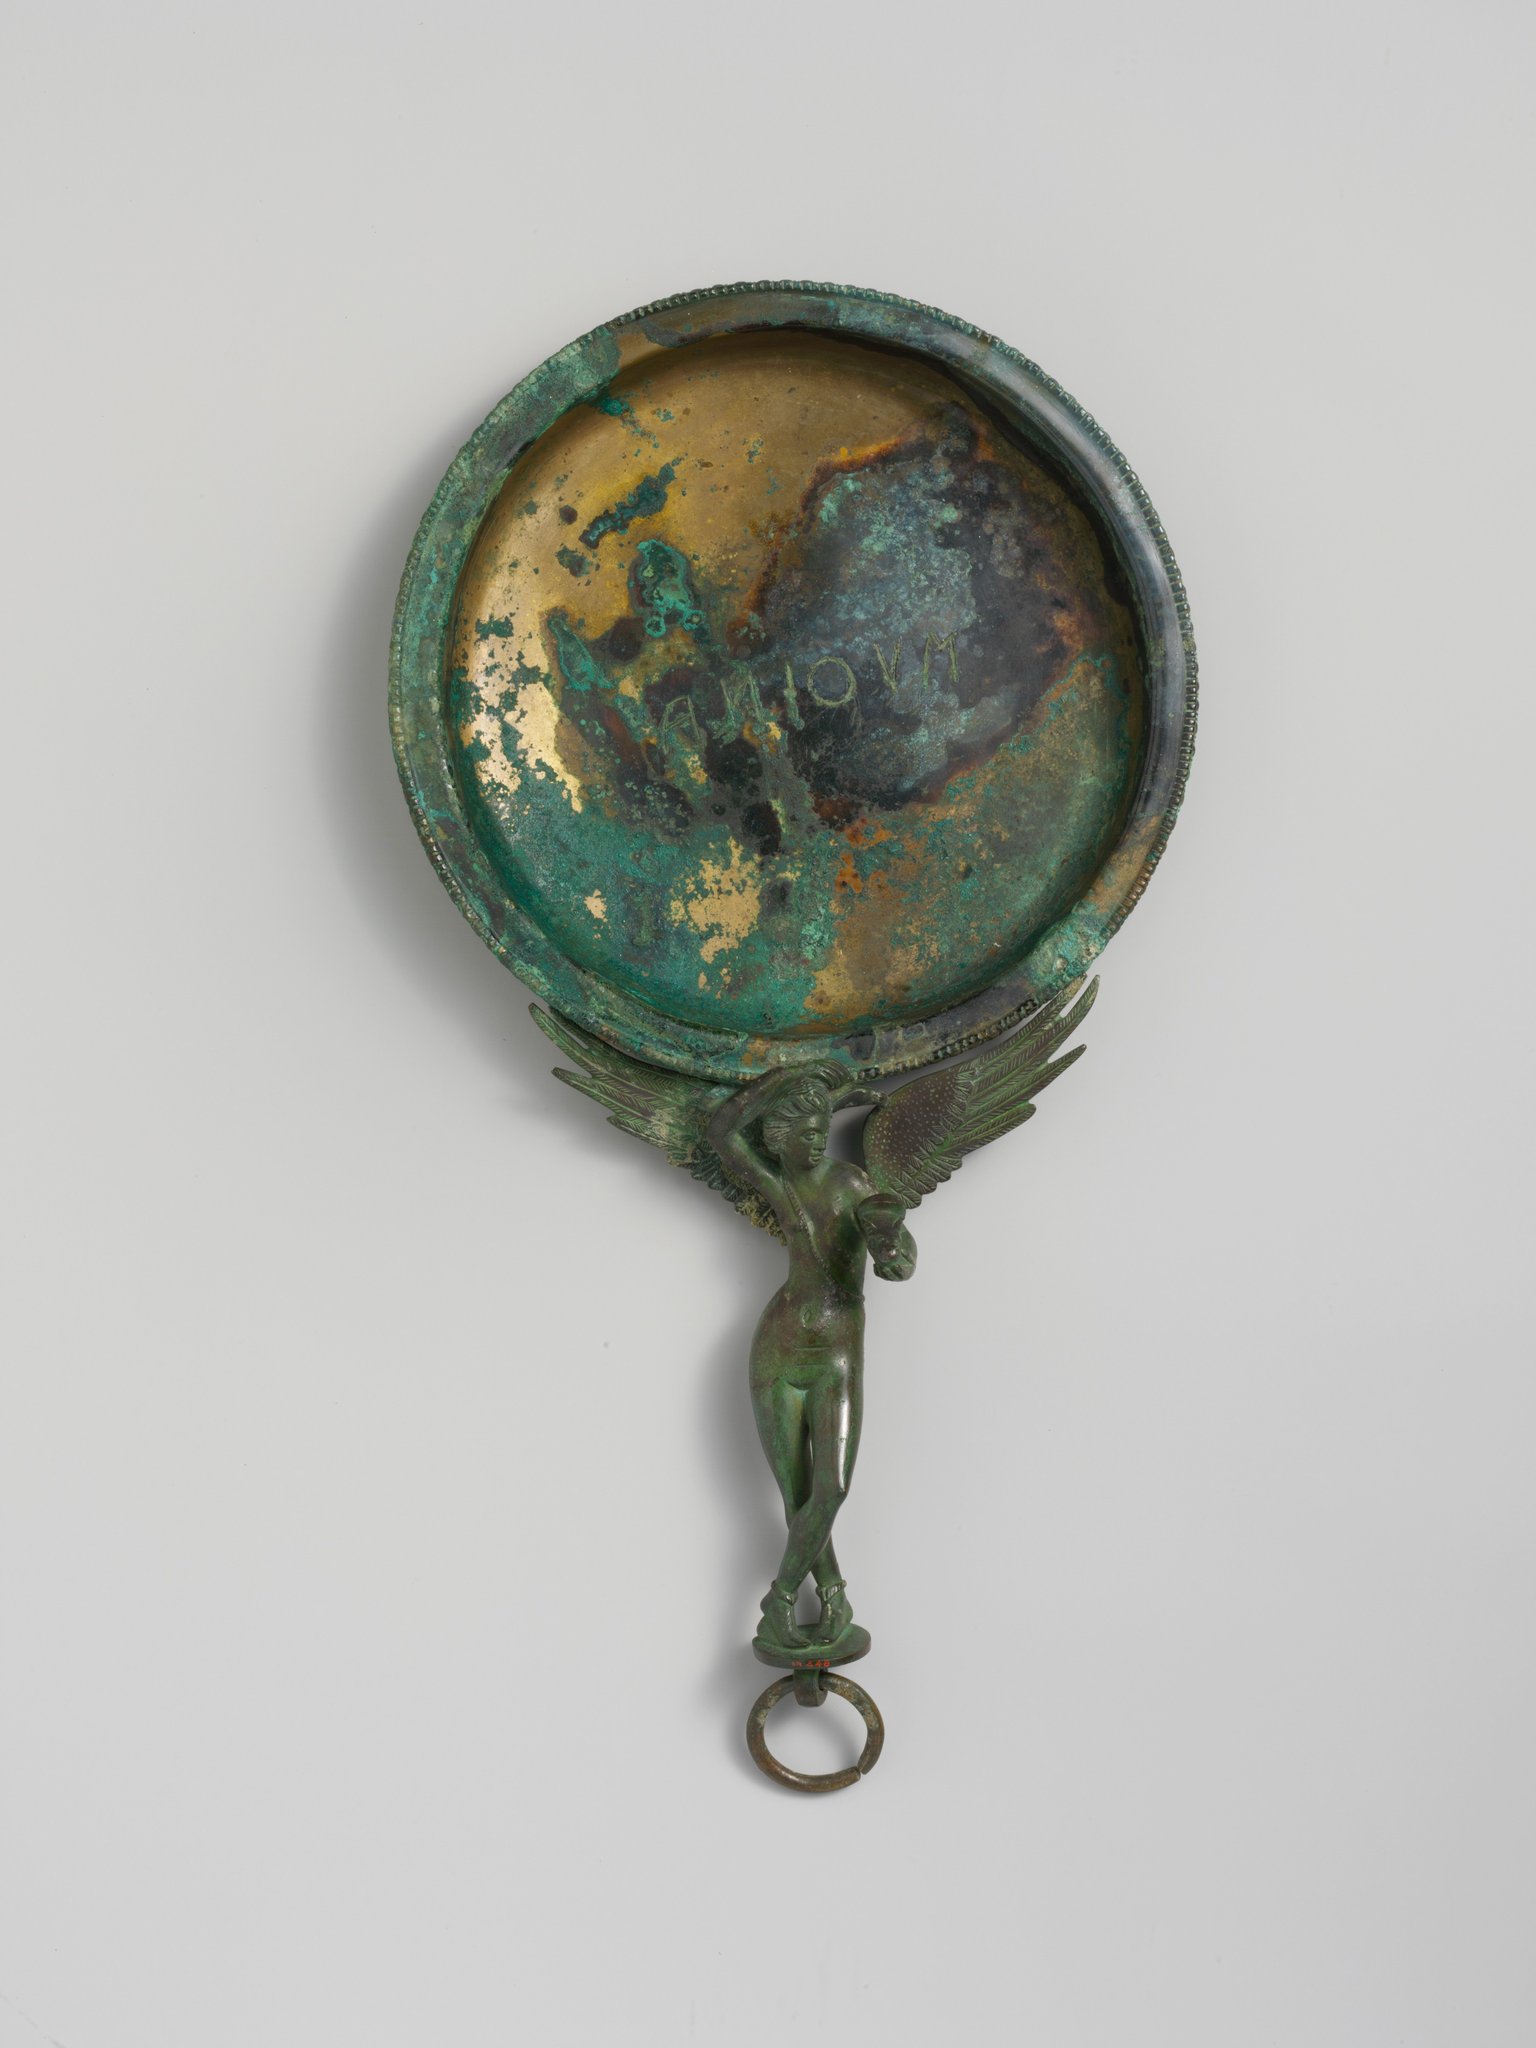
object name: patera with winged lasa, inscribed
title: Bronze patera (shallow bowl with handle)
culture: etruscan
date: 334-268 BCE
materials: bronze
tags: nymphs